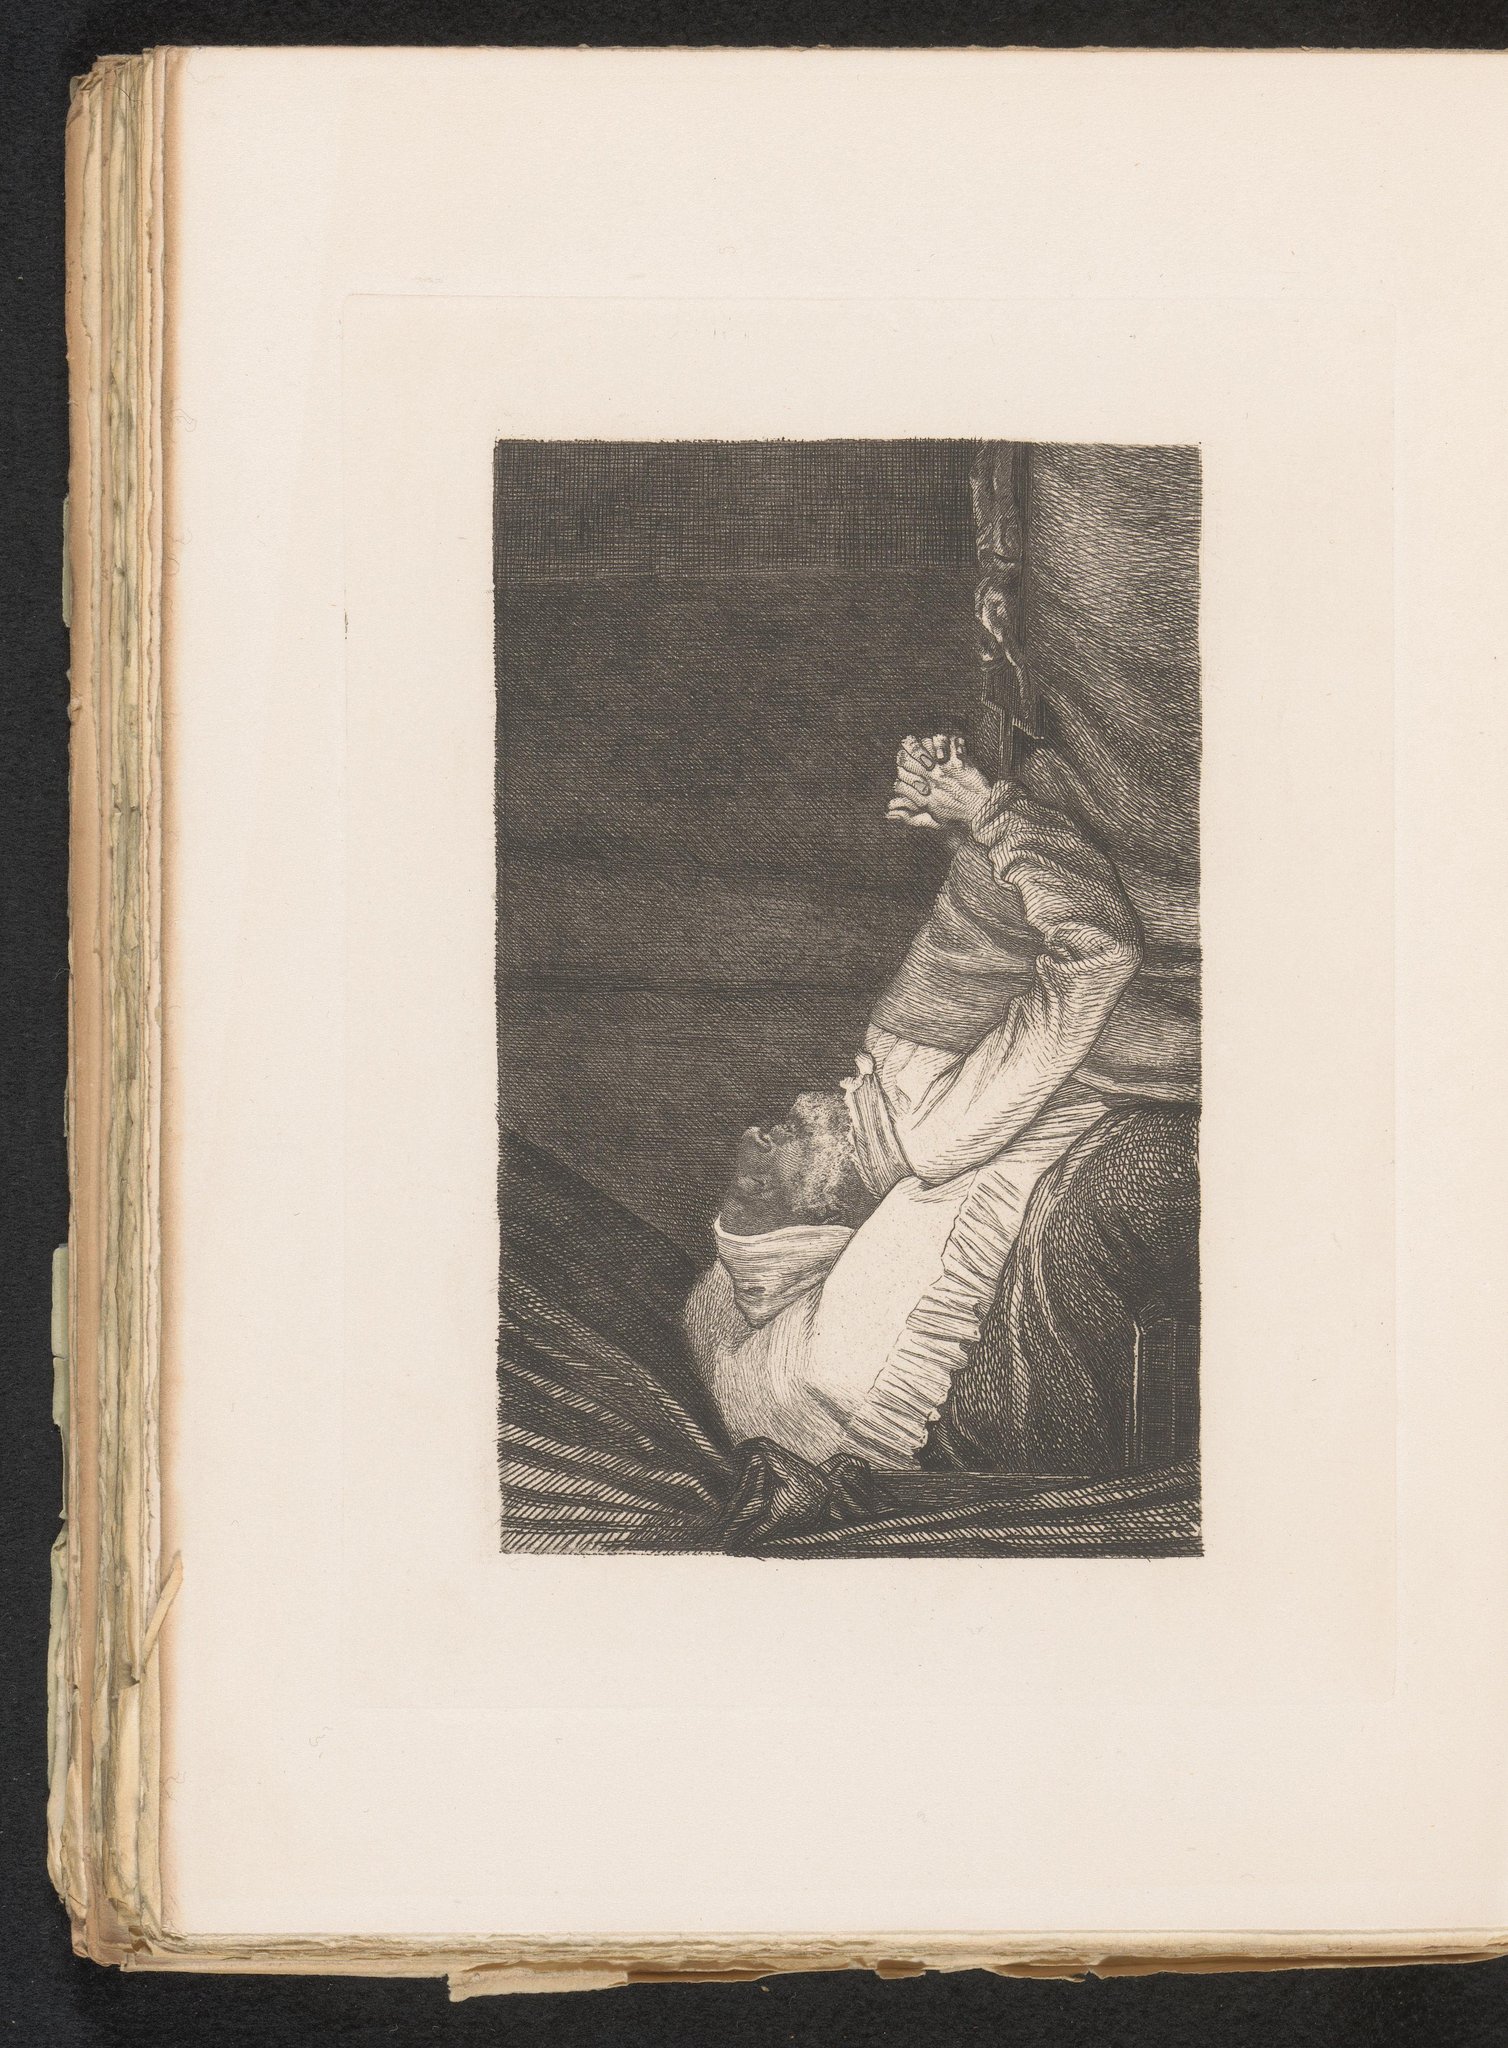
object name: reproduction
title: Fotoreproductie van La chambre mortuaire door Auguste Danse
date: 1879-1884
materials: paper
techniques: photoaquatint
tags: burial rites